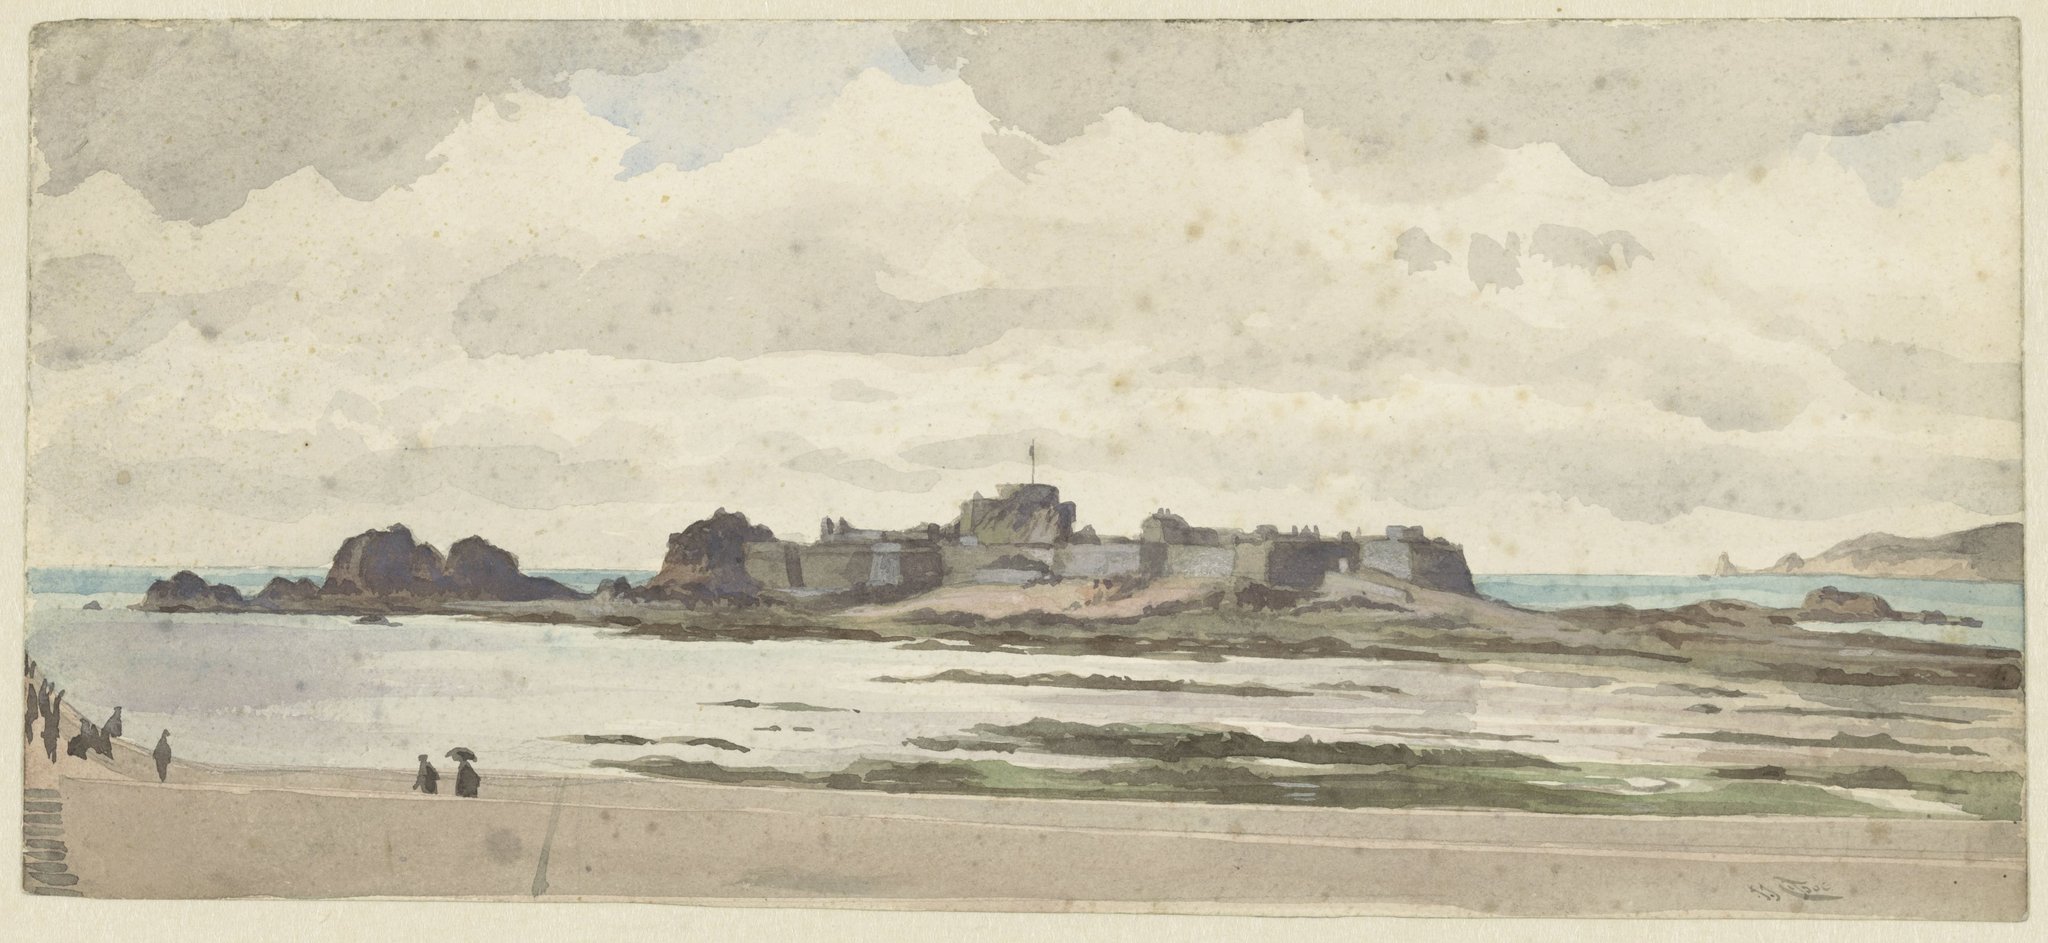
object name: drawing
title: Kasteel of vesting aan de kust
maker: james tissot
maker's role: draughtsman, print maker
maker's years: 1836-1902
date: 1846-1902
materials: paper, watercolor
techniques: brush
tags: fortress, castle, rocky coast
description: Kasteel of vesting aan de kust; op de voorgrond een wandelweg tussen muren.